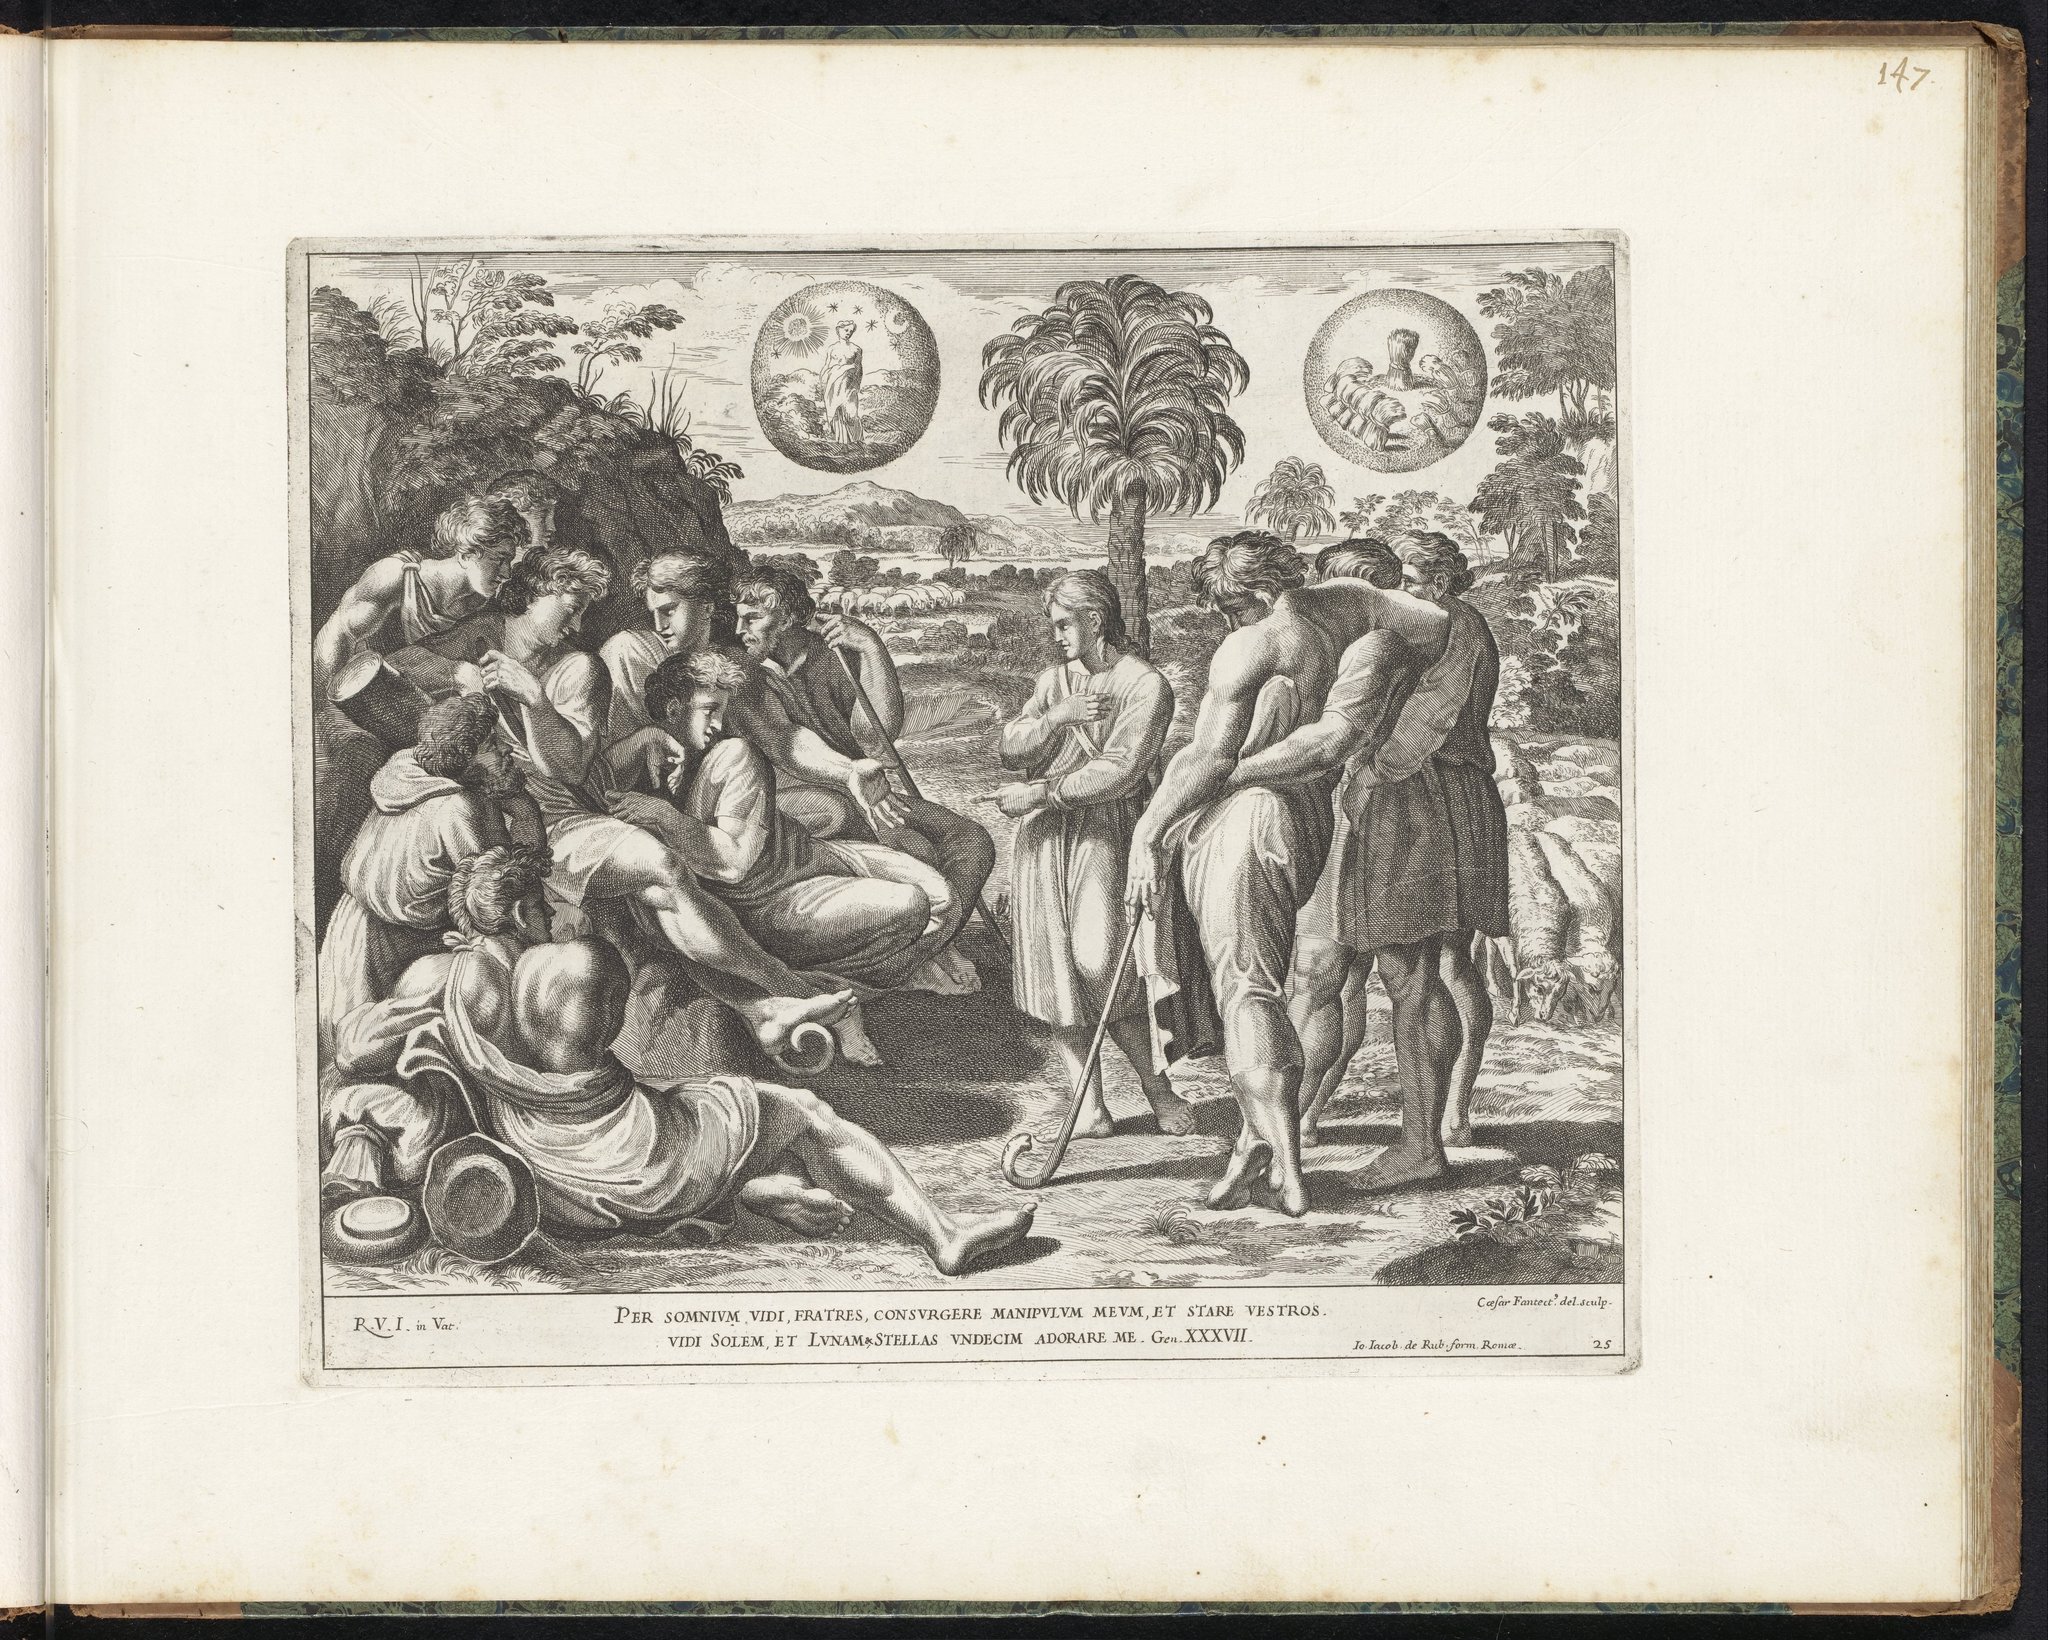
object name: print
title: Schilderingen in de Loggia van Rafaël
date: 1675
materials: paper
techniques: etching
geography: italy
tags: story of joseph (part i), first dream of joseph: the eleven sheaves of wheat of his brothers form a circle round joseph's sheaf and bow down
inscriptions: number: ‘147’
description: Jozef legt zijn droom uit aan zijn broers. Hij vertelt dat in zijn droom de korenschoven van zijn broers bogen voor zijn eigen schoof en dat ook de zon, maan en sterren voor hem bogen. Bijbelvers onder de voorstelling. Prent maakt deel uit van een album.